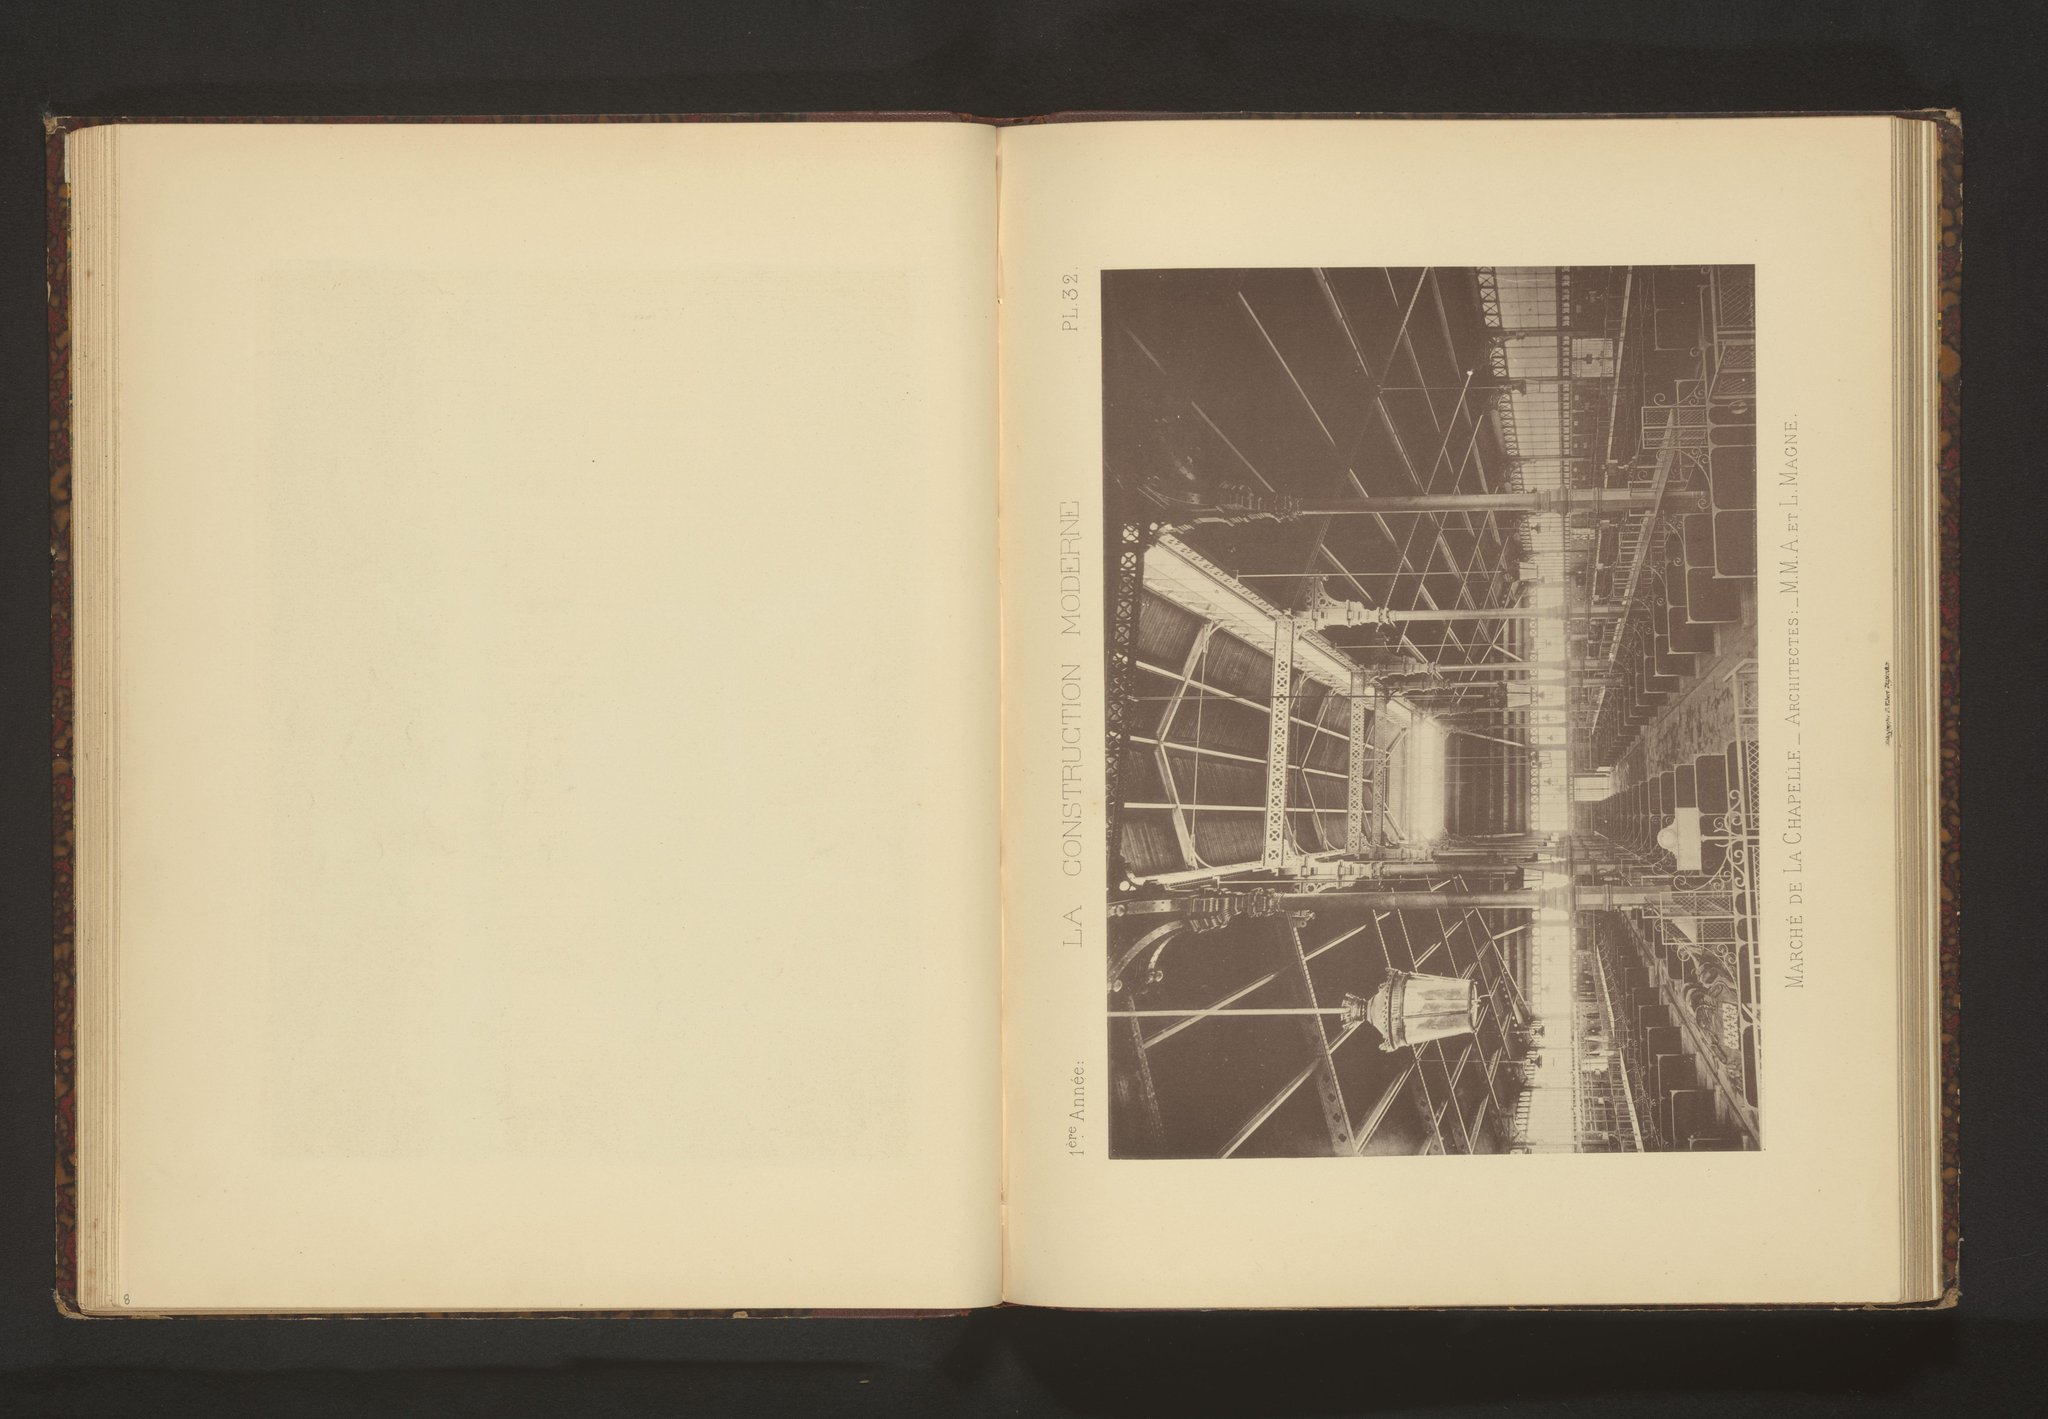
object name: photomechanical print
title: Marché de La Chapelle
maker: paul dujardin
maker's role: print maker, printer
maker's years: 1843-1913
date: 1881-1886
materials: paper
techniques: photograph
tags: market-hall, paris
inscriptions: inscription: ‘Architectes: M.M.A. et L. Magne.’, inscription: ‘1ère Année: LA CONSTRUCTION MODERNE Pl. 32’